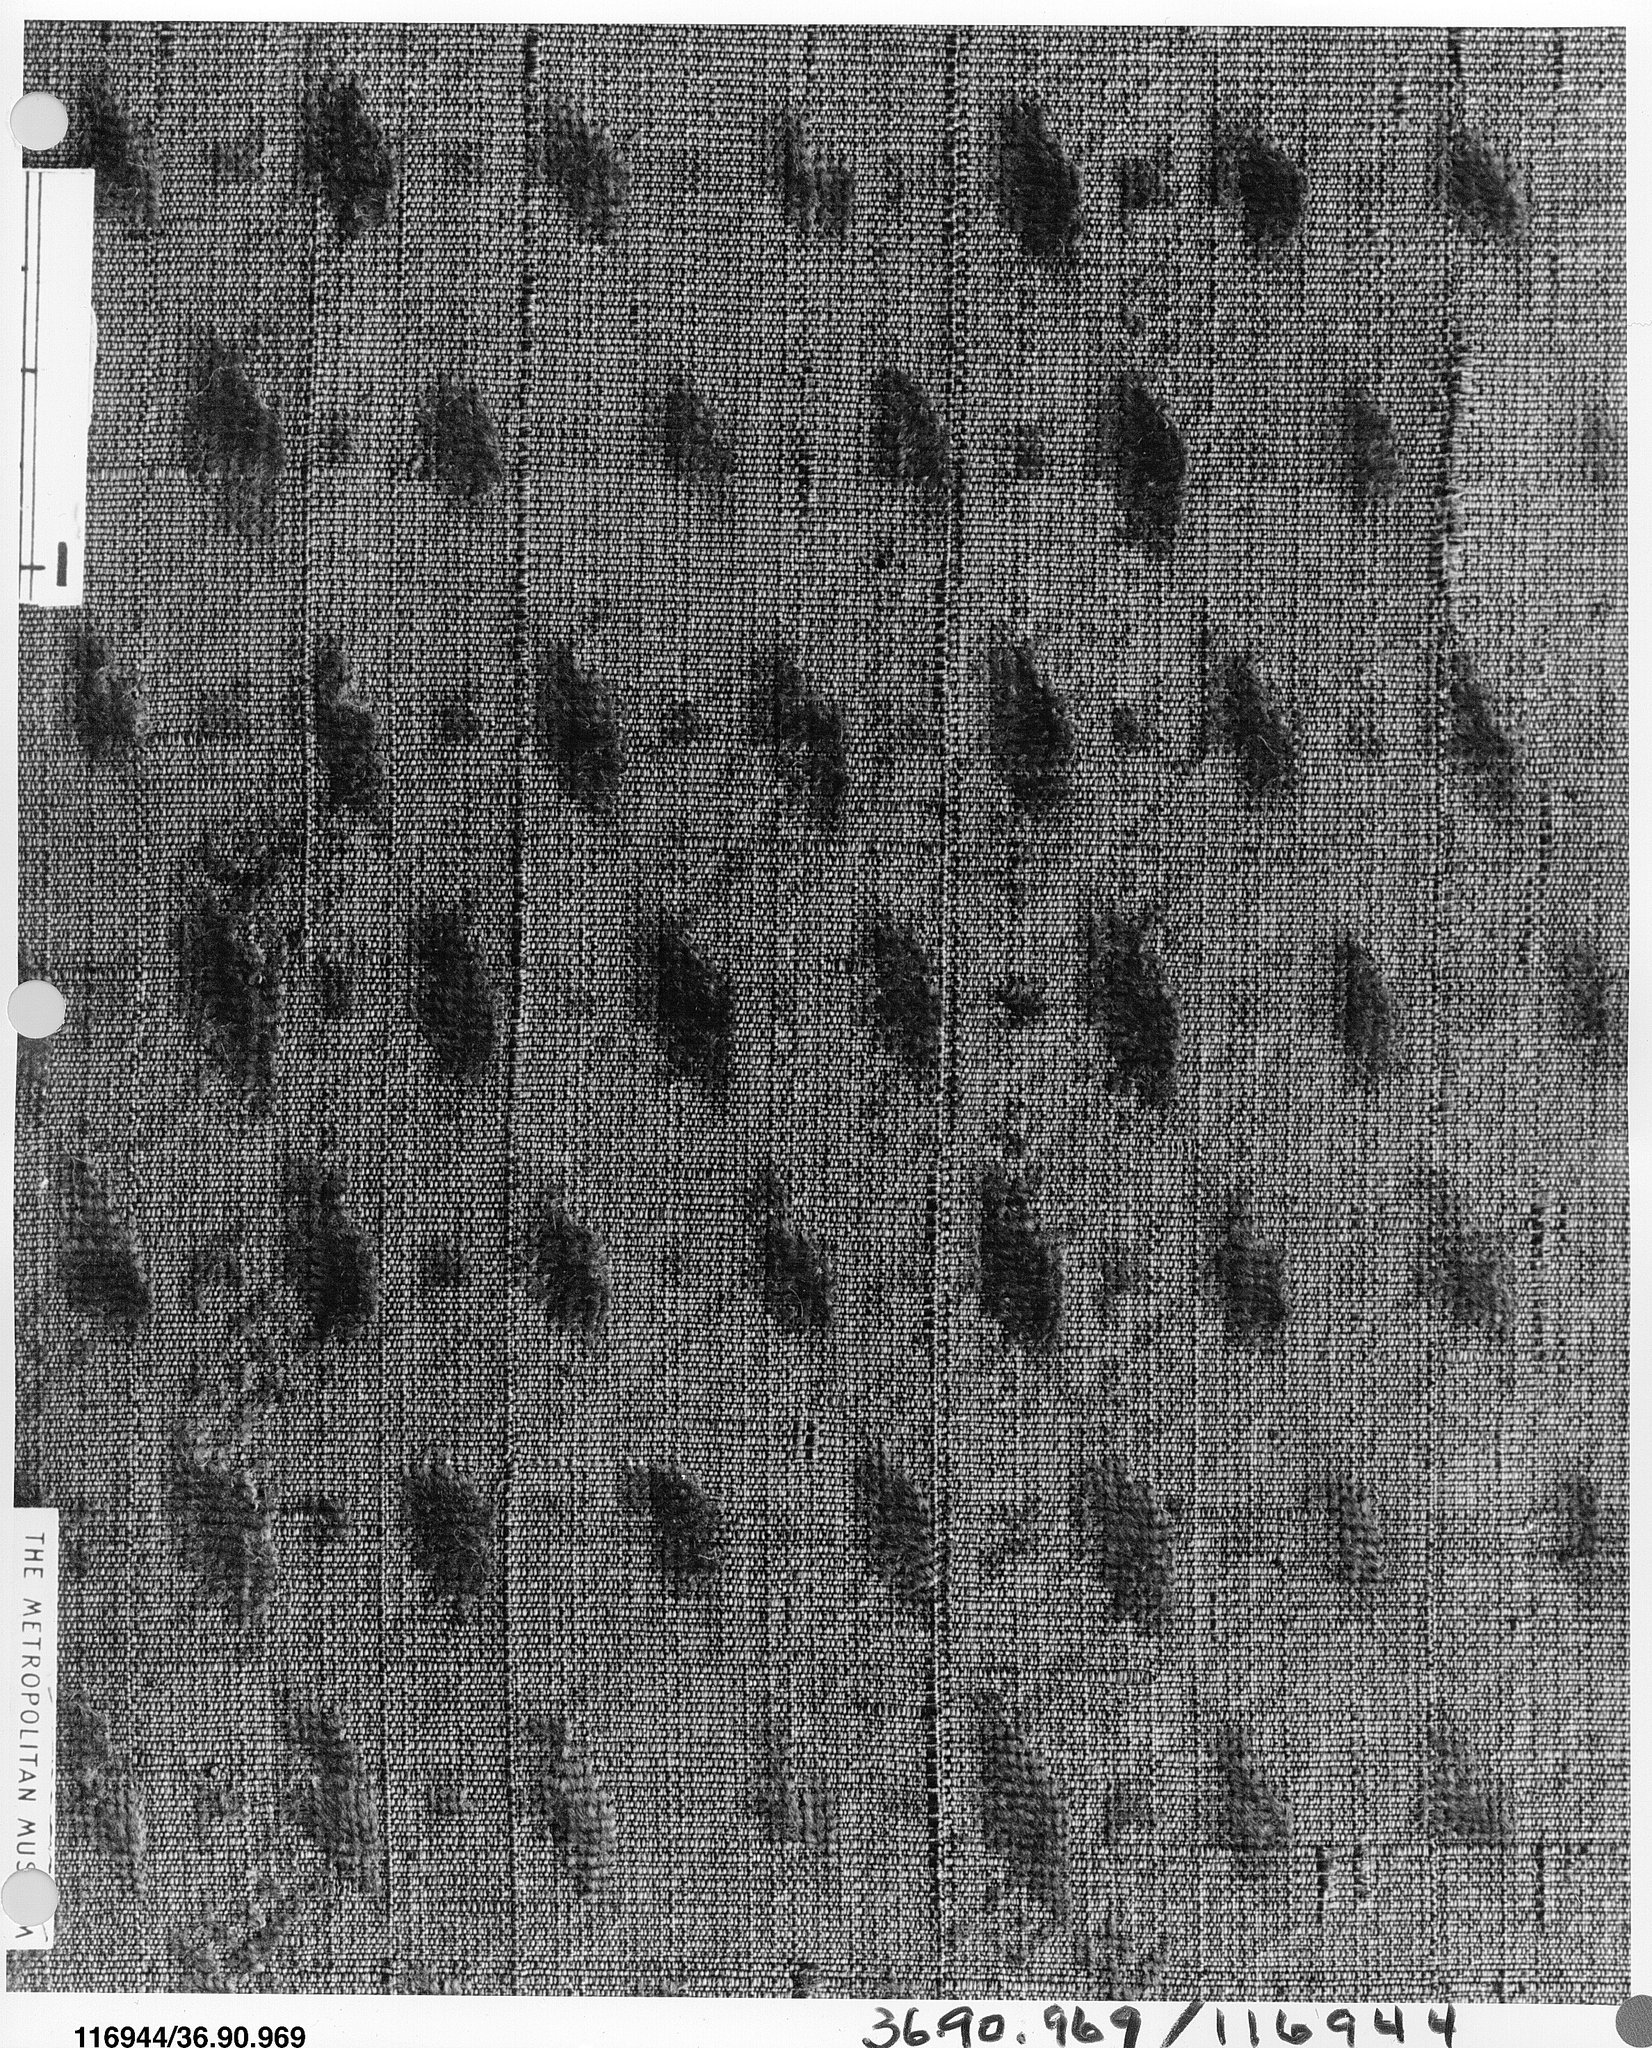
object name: piece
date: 1601-1700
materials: silk